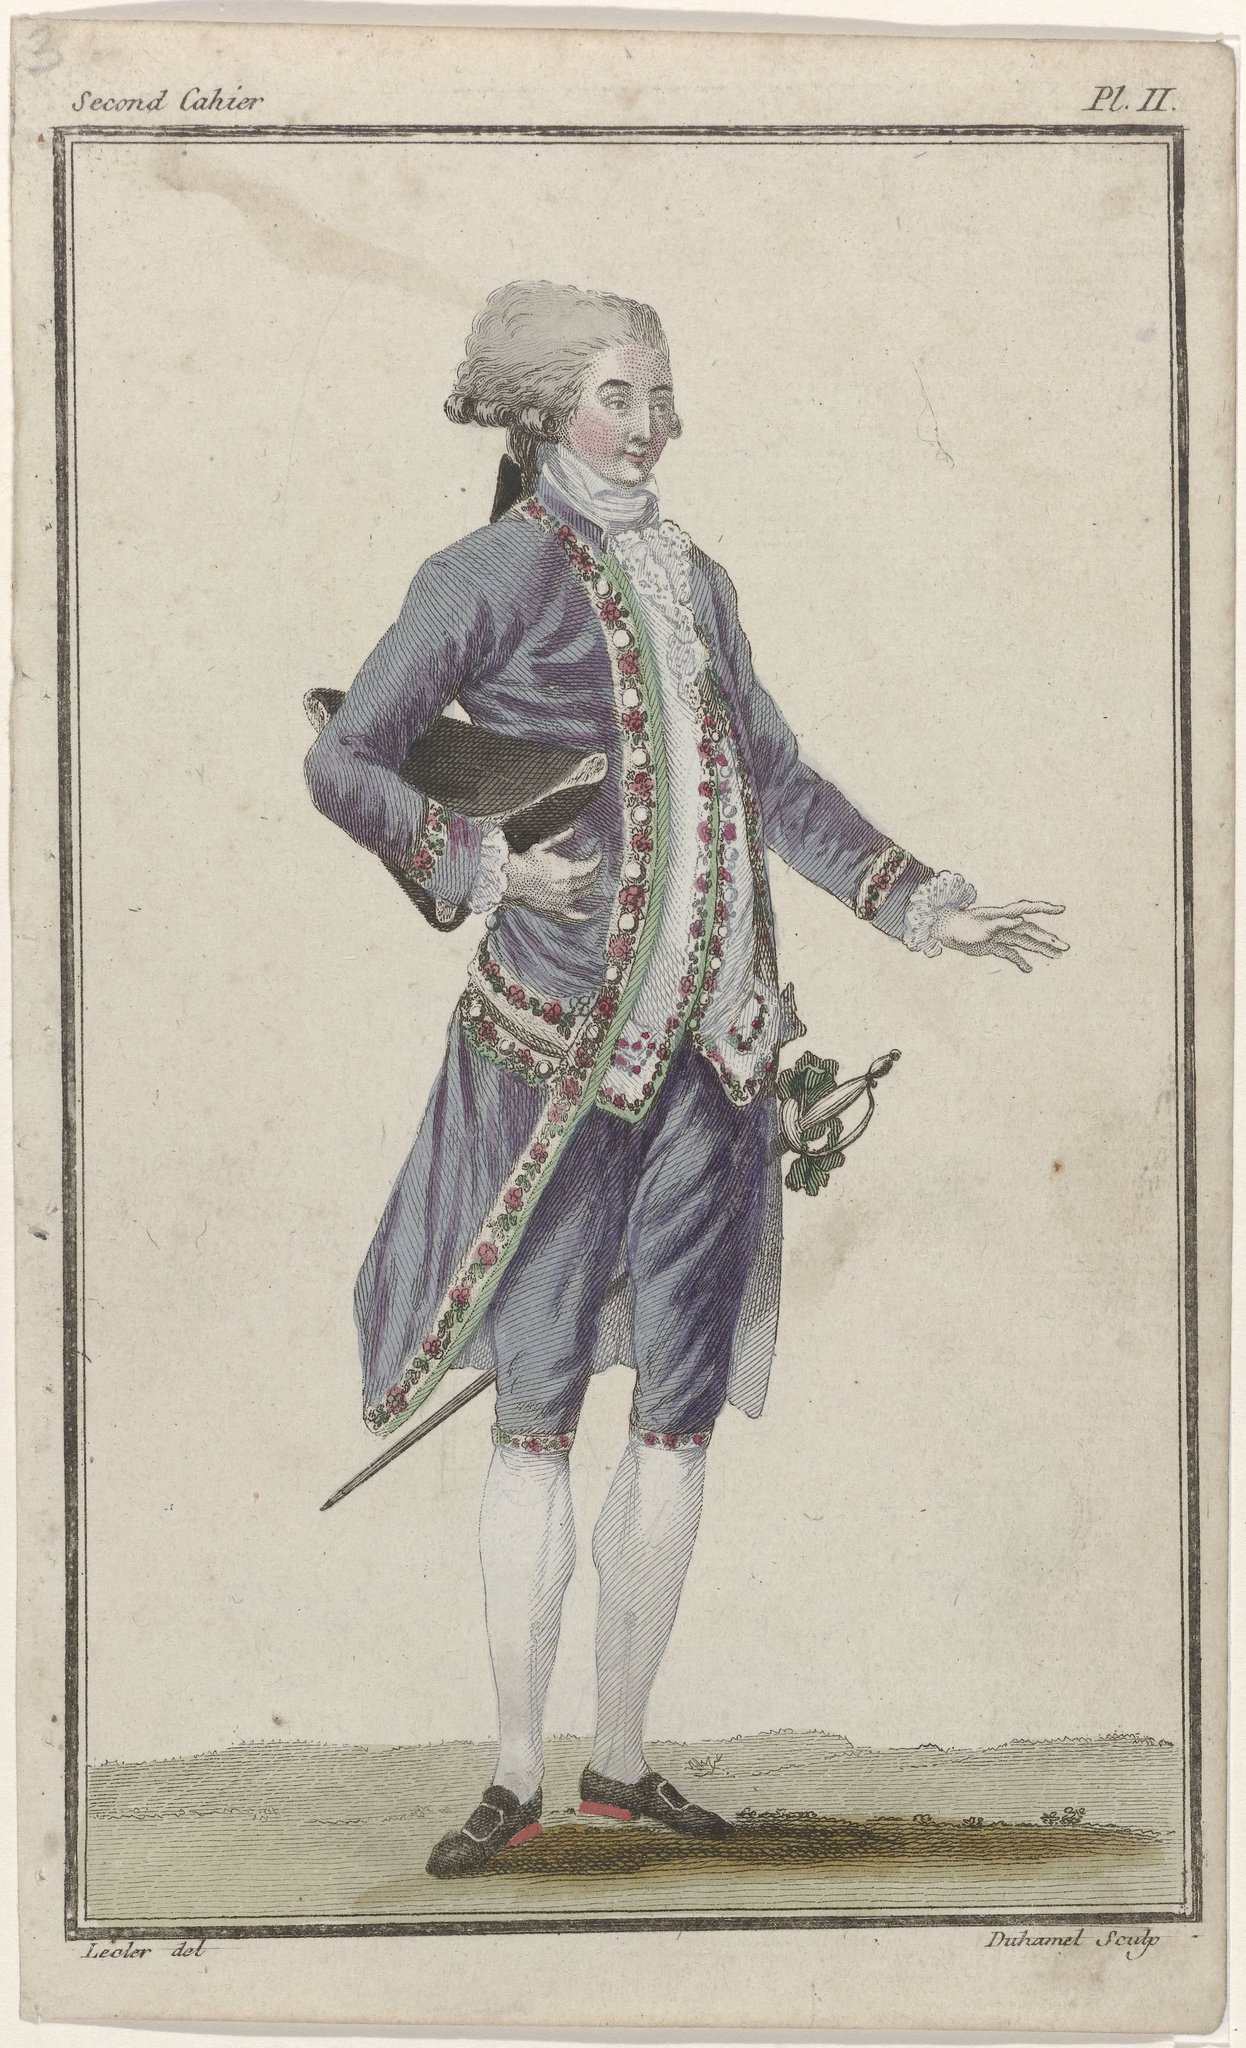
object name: fashion print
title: Cabinet des Modes ou les Modes Nouvelles, 2e Cahier, 1 décembre 1785, Pl. II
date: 1785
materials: paper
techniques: engraving, hand coloring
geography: paris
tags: head-gear: tricorn (+ men's clothes), clothing for the upper part of the body (vest) (+ men's clothes), neck-gear ~ clothing (+ men's clothes), hacking and thrusting weapons, coat (+ men's clothes), fashion plates, shoes, sandals (+ men's clothes), trousers, breeches, etc. (breeches) (+ men's clothes), stockings, socks (+ men's clothes)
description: Volgens de begeleidende tekst toont de prent een man in 'grande Parure': een habit van paars satijn, geborduurd met roze en groene zijde, een geborduurd vest van wit satijn en satijnen kniebroek in dezelfde kleur als de jas, met geborduurde kousenbanden. Witte zijden kousen. Zijn kapsel wordt 'grecque carré' genoemd en heeft 3 krullen. Hoed met witte veer onder de arm. Degen aan de linkerzijde. Gerimpelde jabot en manchetten. Driekantige steek onder de arm. Schoenen met gespen en rode hakken. De prent maakt deel uit van het 2e Cahier uit Cabinet des Modes ou les Modes Nouvelles. De serie bestaat uit 72 modeprenten, uitgegeven door Buisson, Parijs, 15 november 1785 - 1 november 1786.